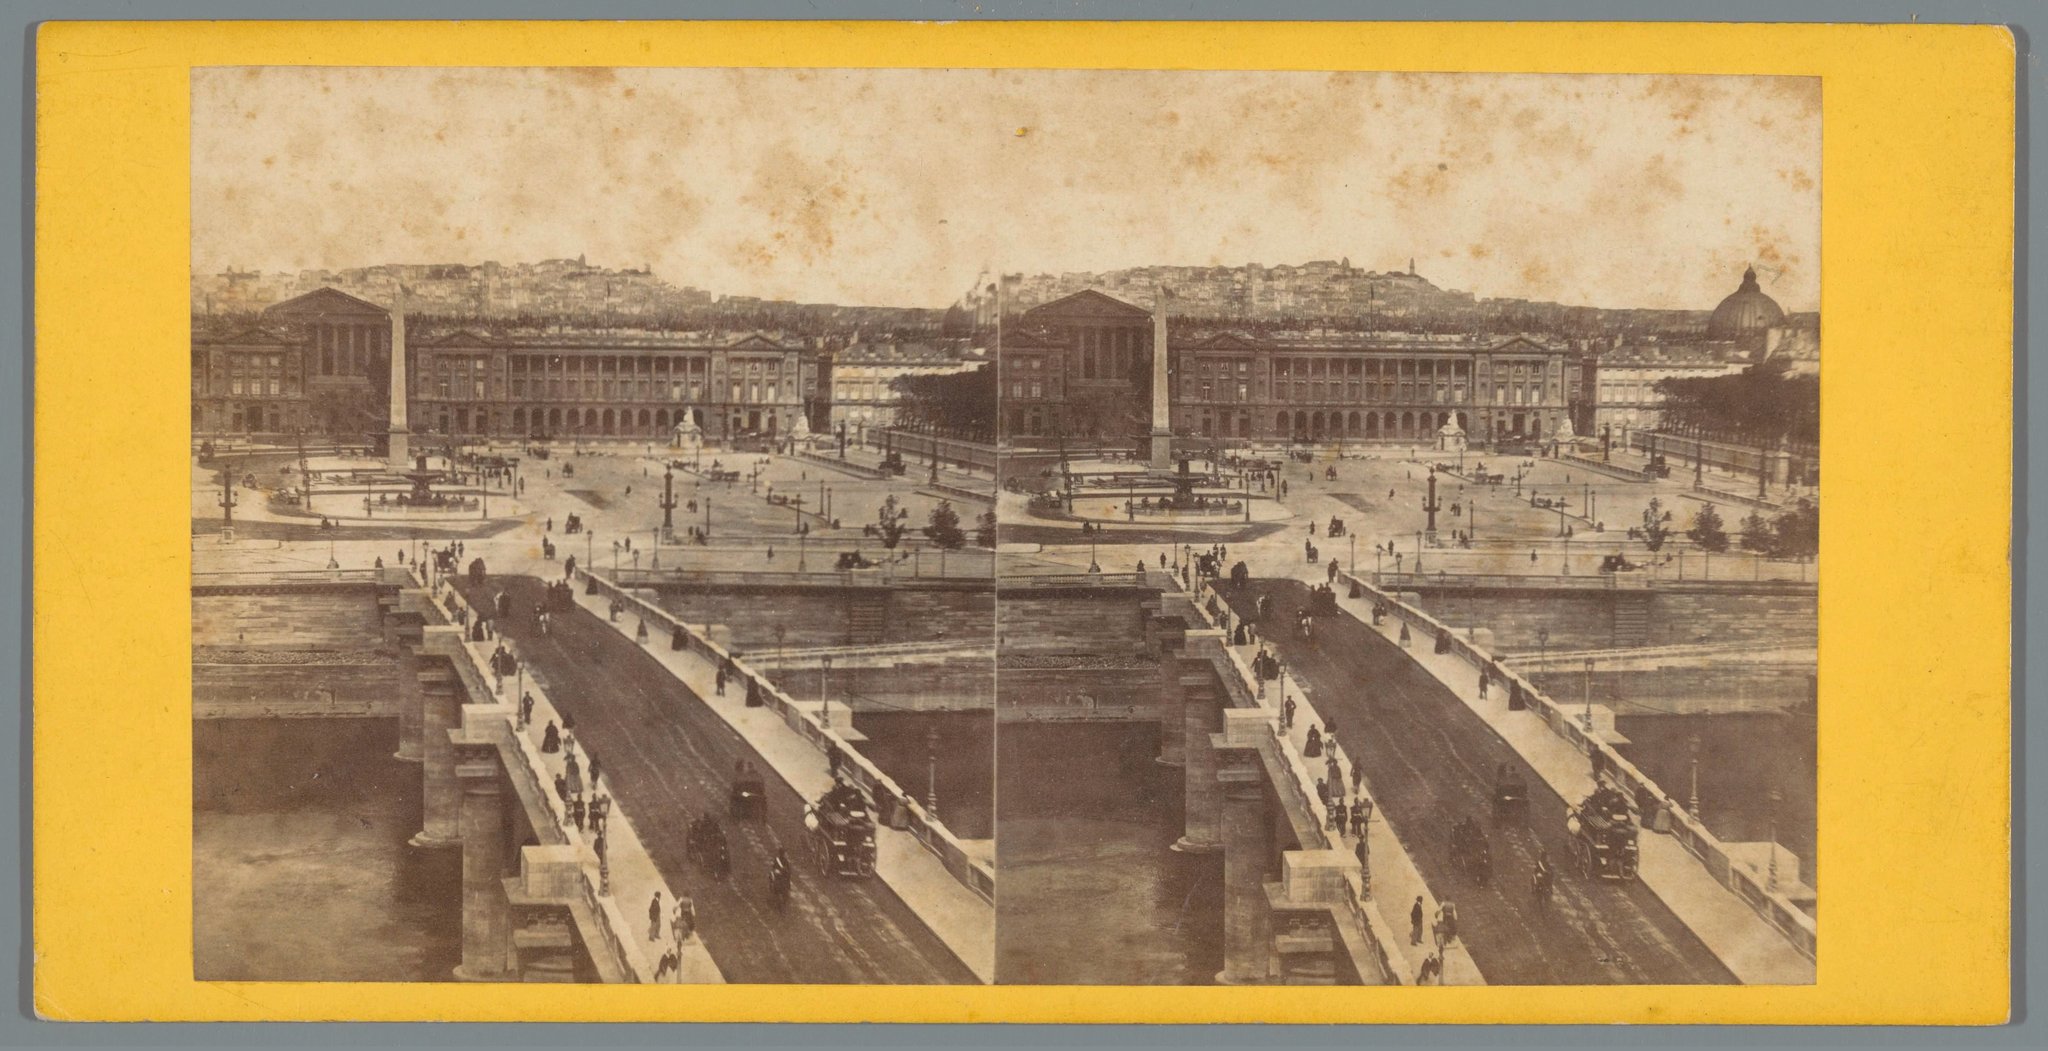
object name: stereograph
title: Gezicht op de Pont de la Concorde, Place de la Concorde en La Madeleine in Parijs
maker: Anonymous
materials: cardboard, photographic support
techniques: albumen print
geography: paris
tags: square, place, circus, etc., obelisk, needle, bridge in city across river, canal, etc.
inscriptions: inscription: ‘Place de la Concorde Aug-Sept. 68. L[...]’